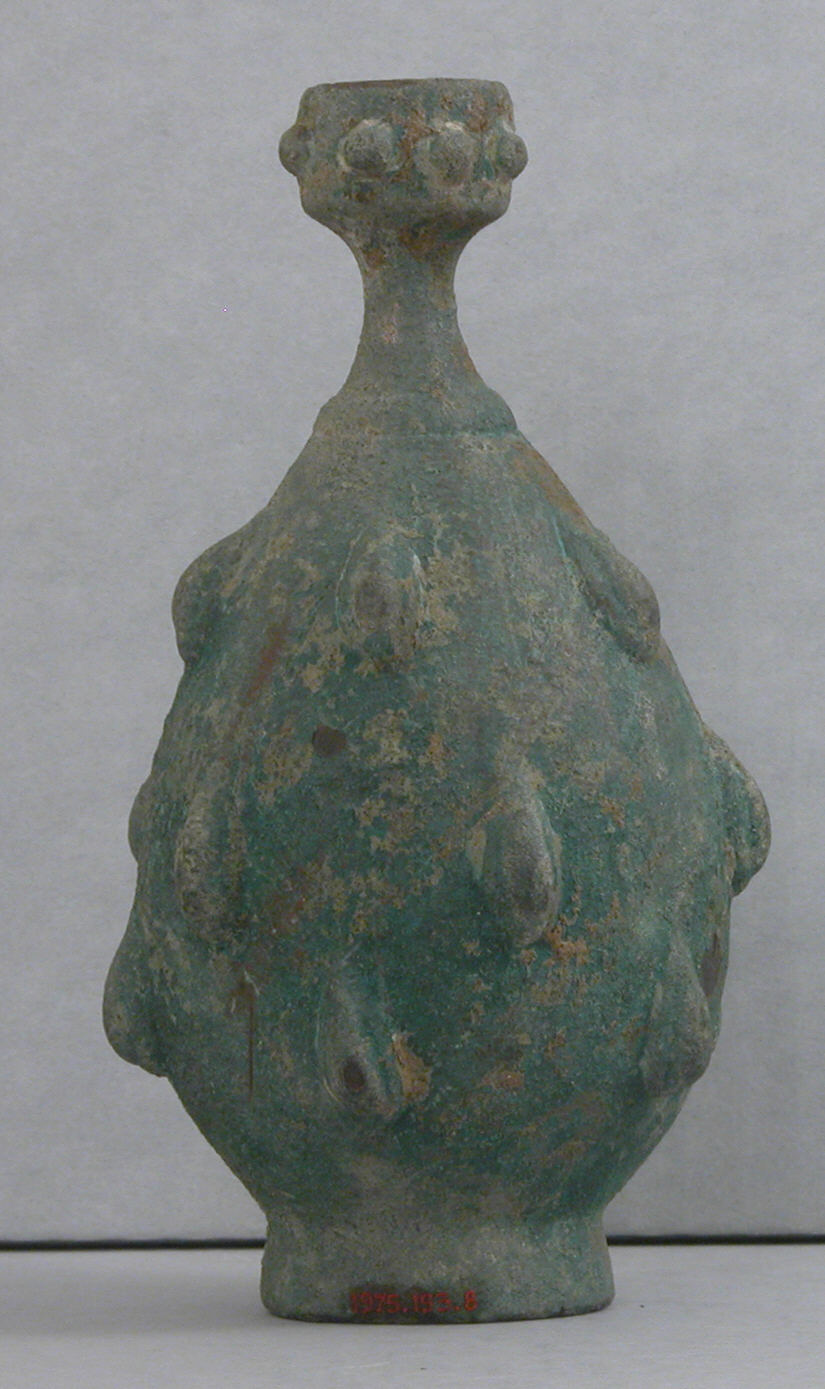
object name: flask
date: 701-900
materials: bronze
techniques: casting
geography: iran